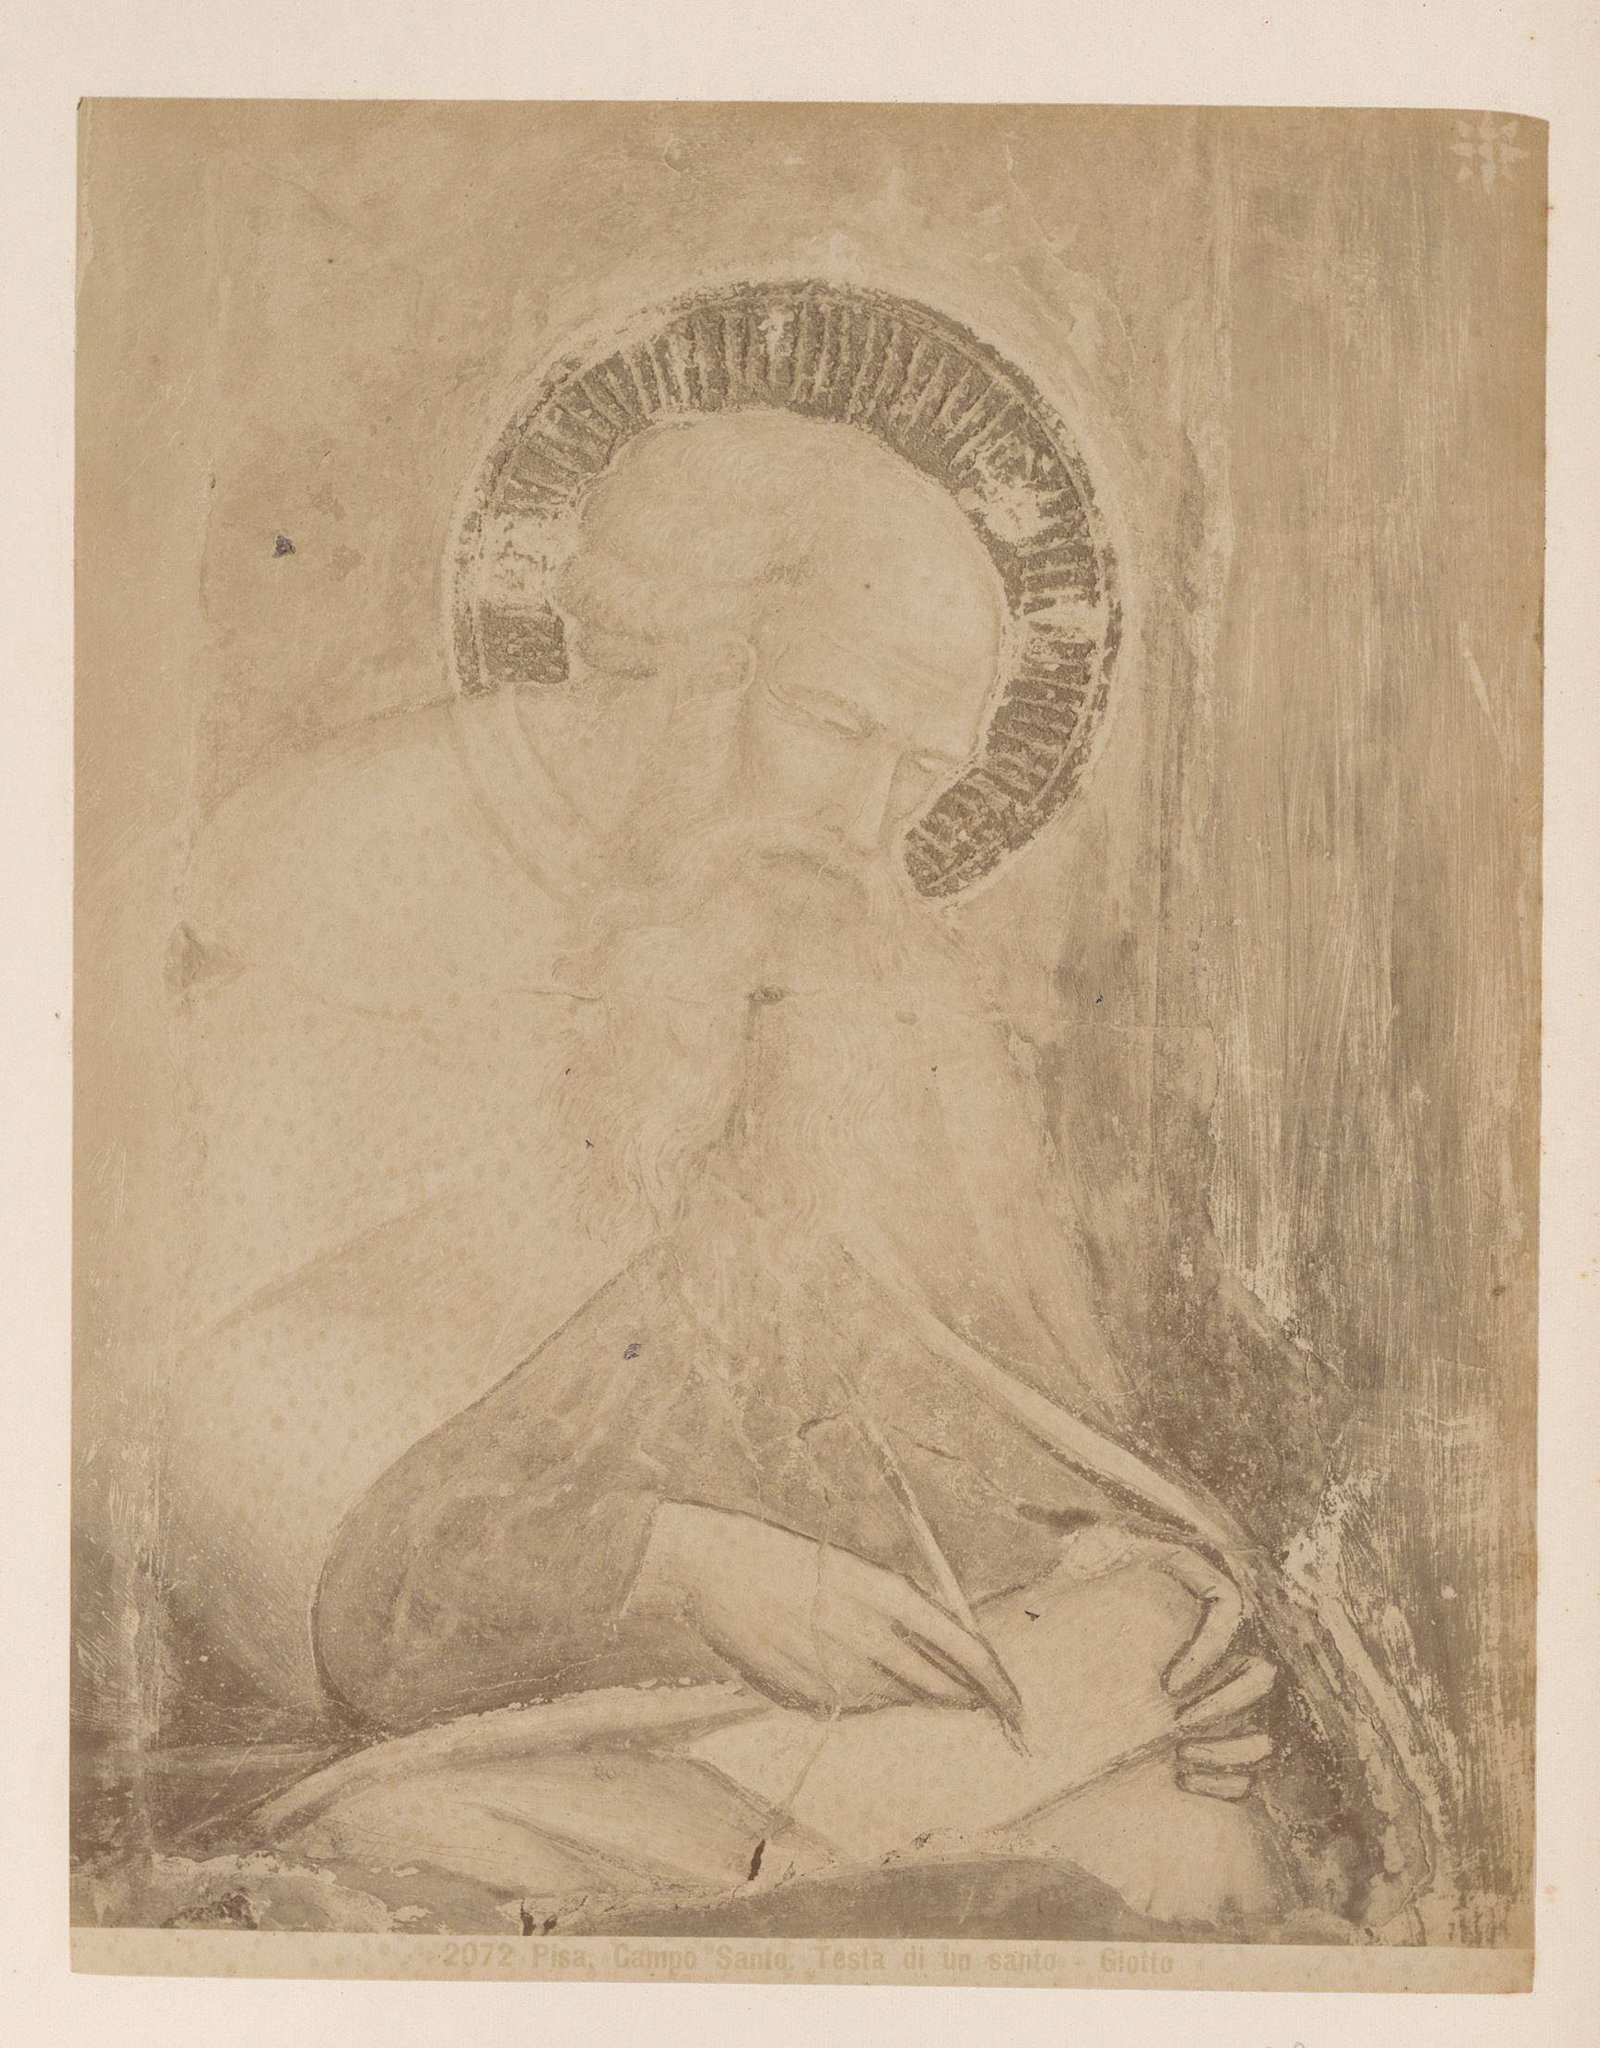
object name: photograph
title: Fotoreproductie van het fresco Kop van een heilige door Giotto in het Camposanto te Pisa, Italië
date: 1860-1881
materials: paper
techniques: albumen print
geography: pisa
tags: picture, painting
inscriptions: number: ‘2072’